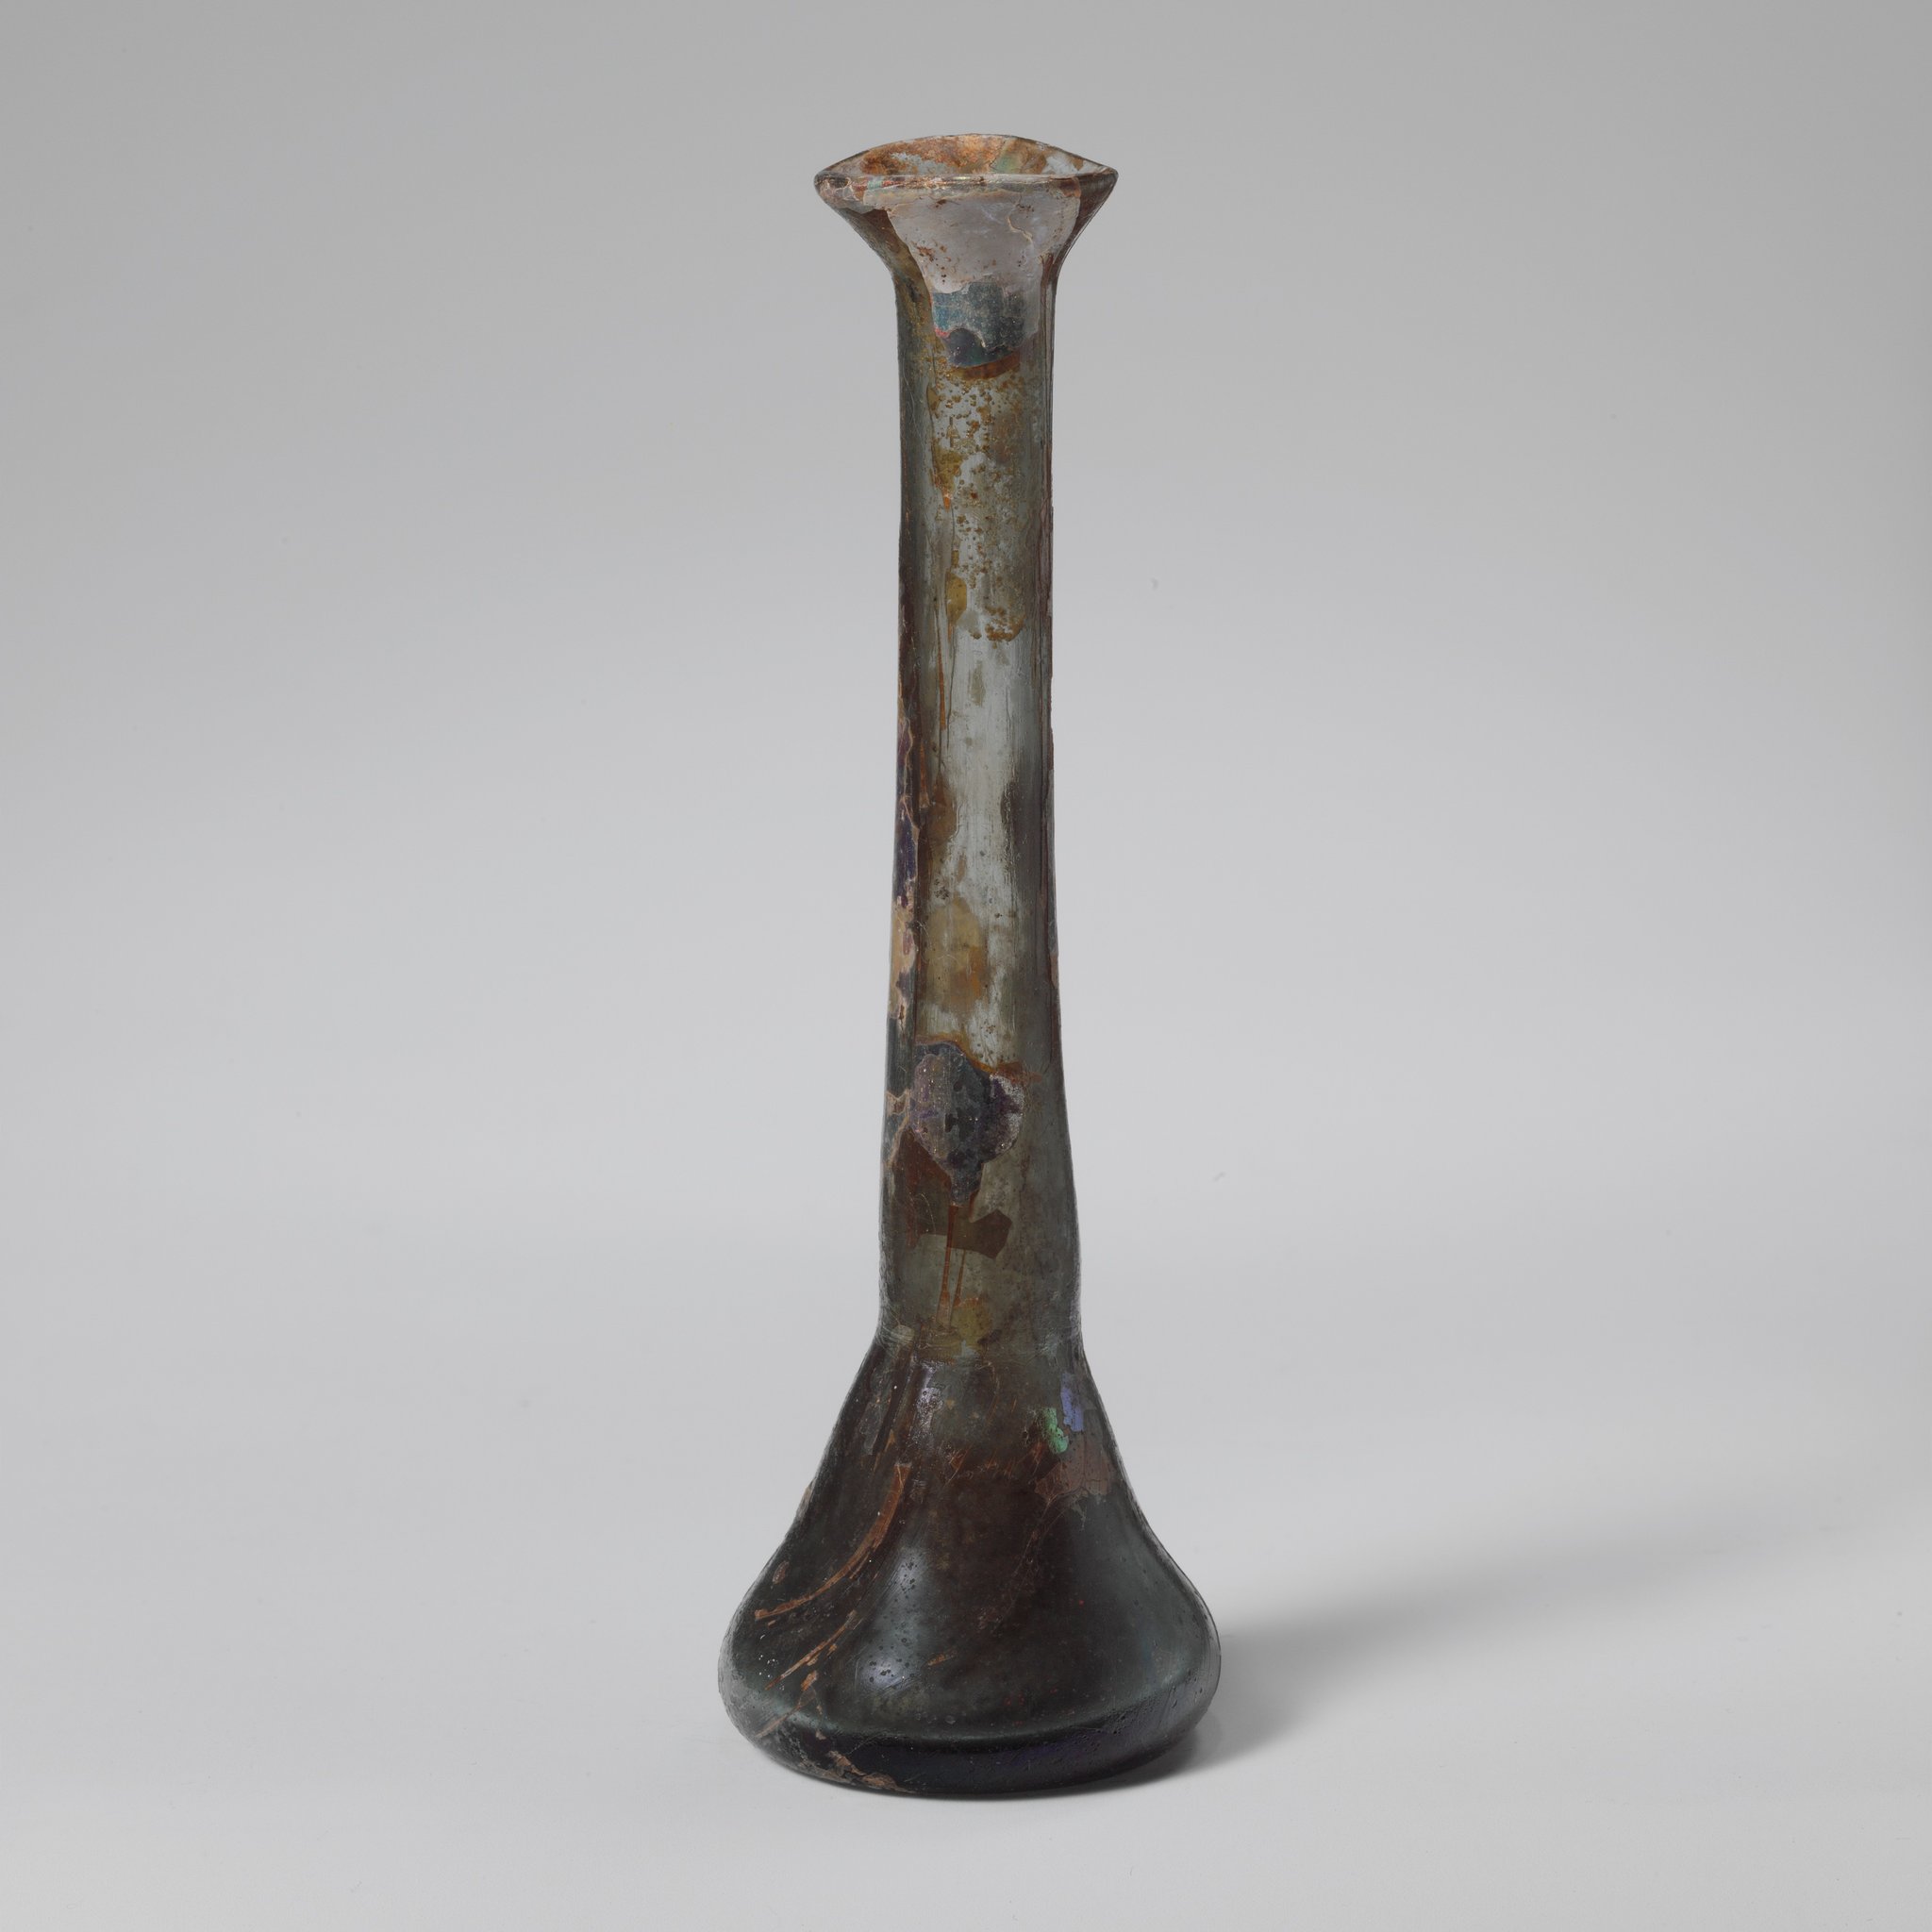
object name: perfume bottle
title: Glass perfume bottle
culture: roman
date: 101-300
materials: glass